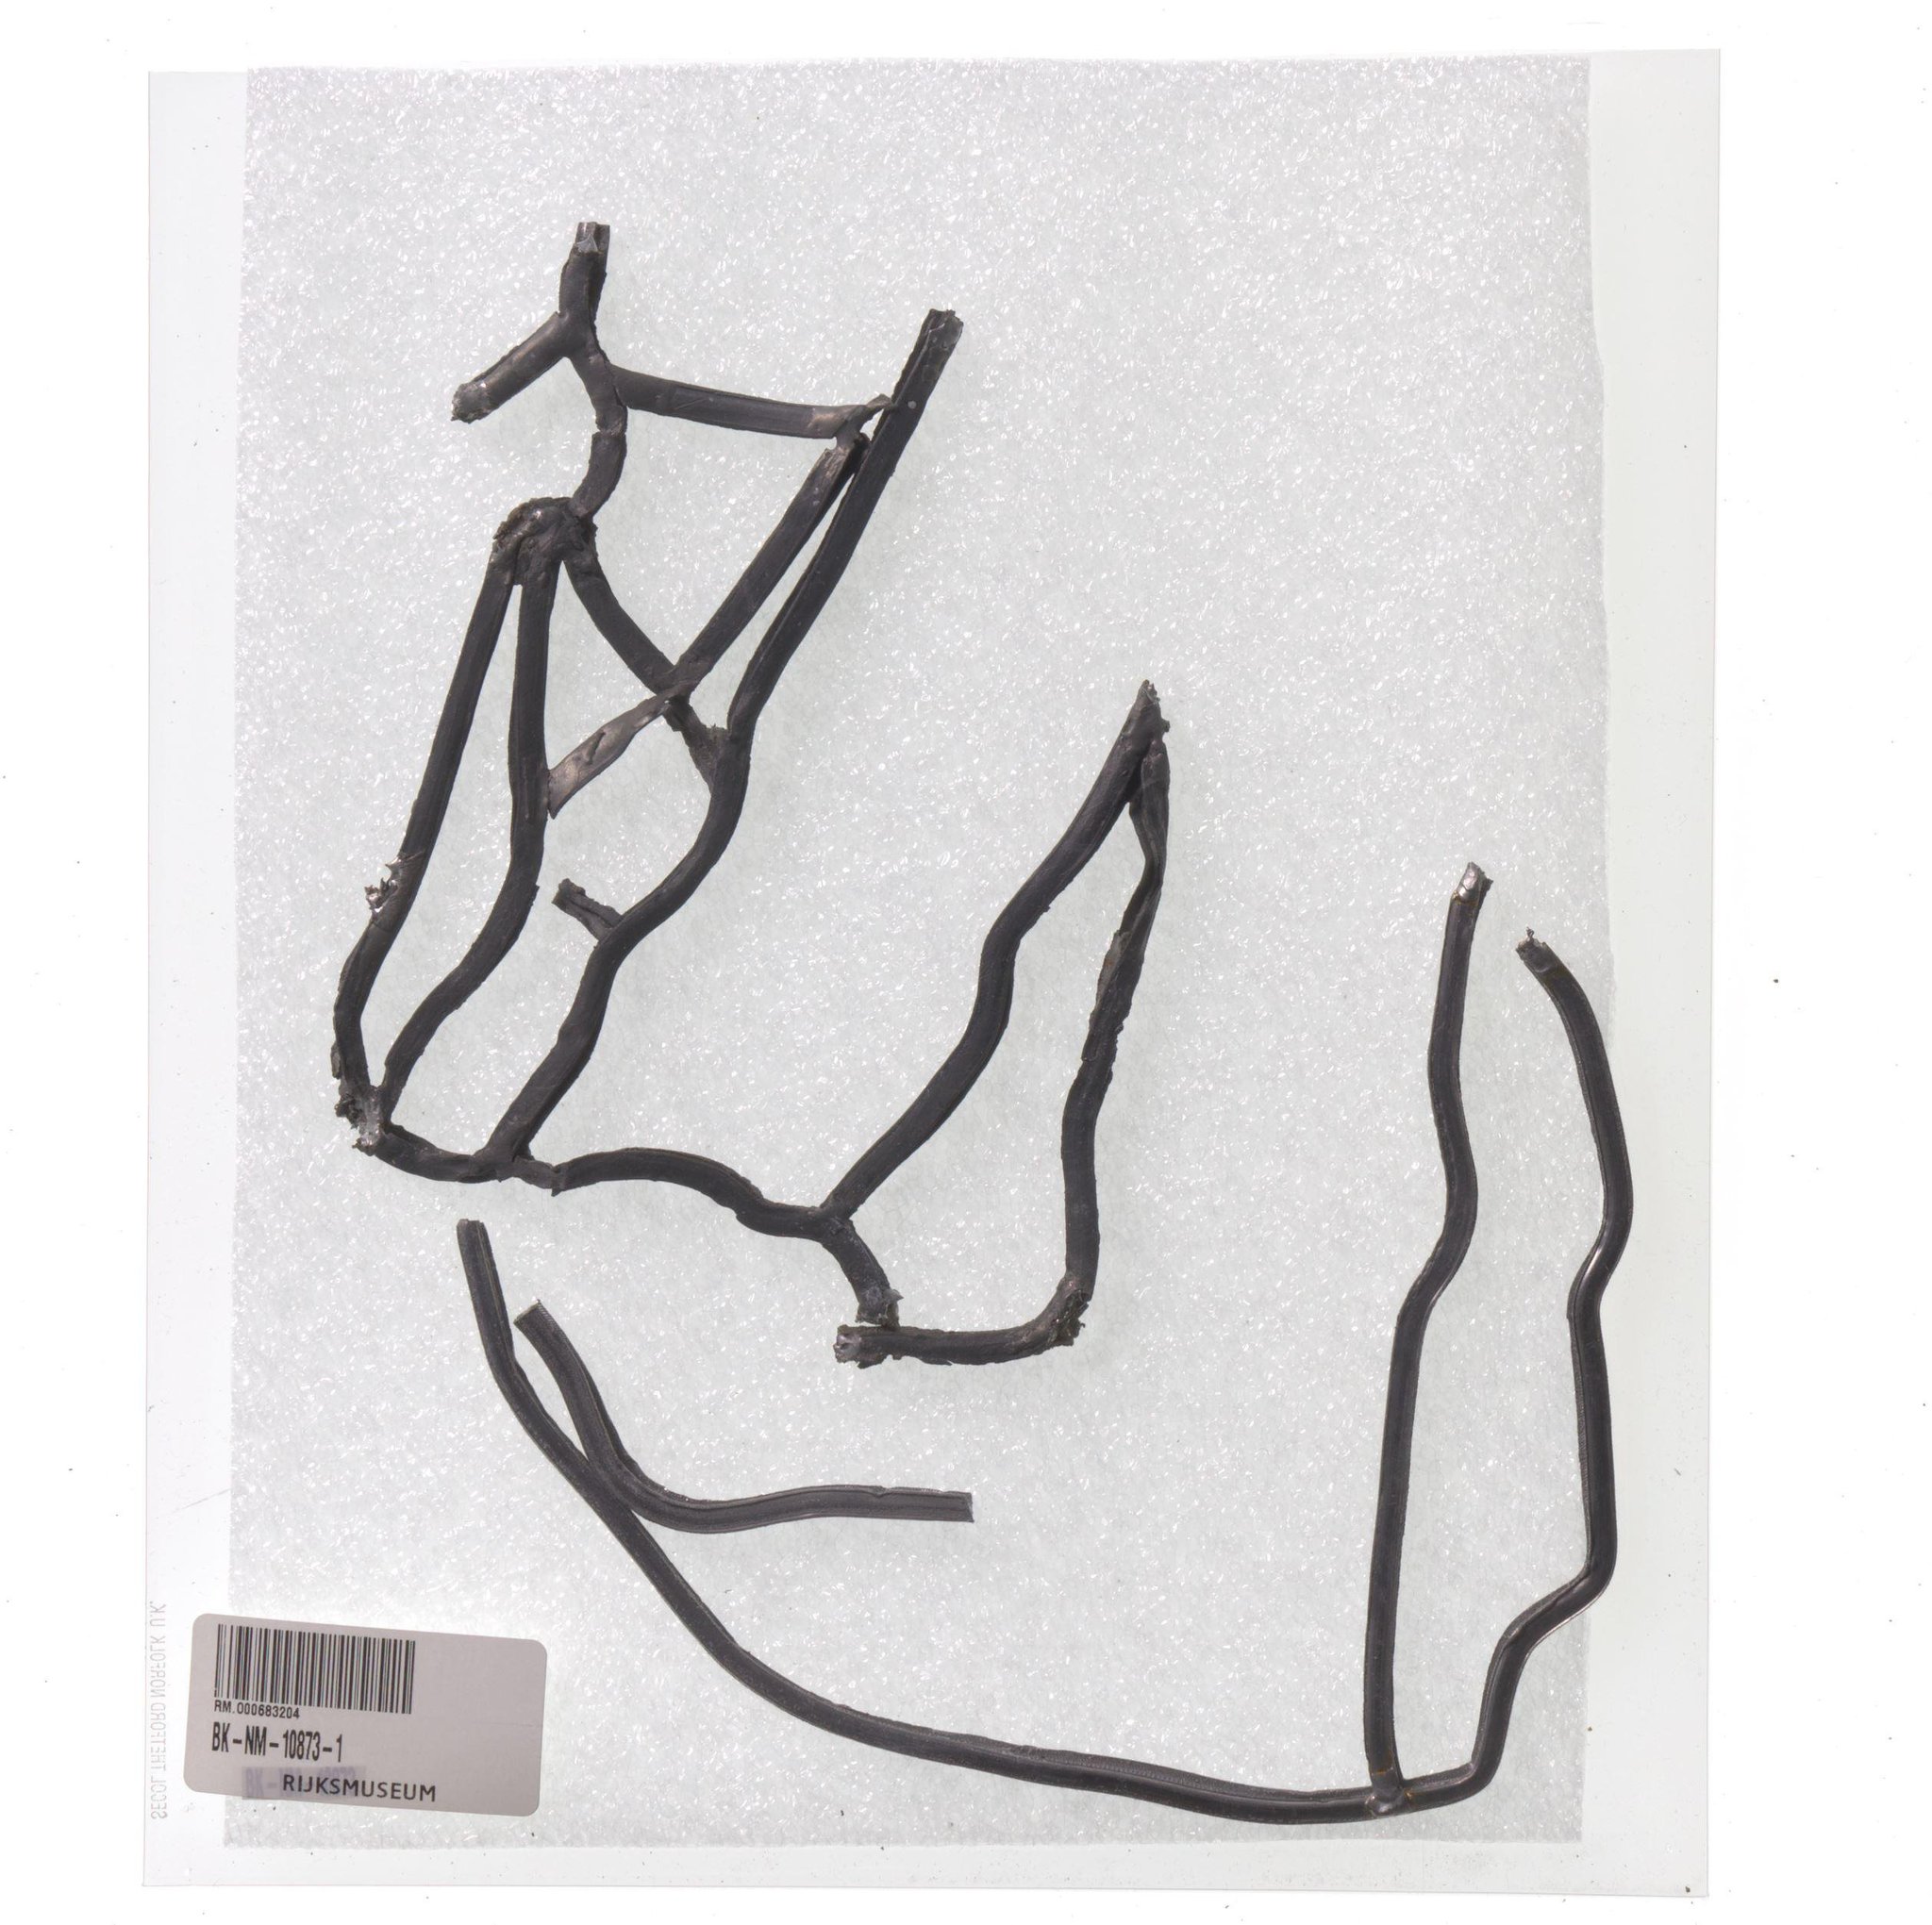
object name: light window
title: Lood voor de ruit met het hoofd van Johannes de Doper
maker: Anonymous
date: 1400-1450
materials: lead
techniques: leading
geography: southern netherlands